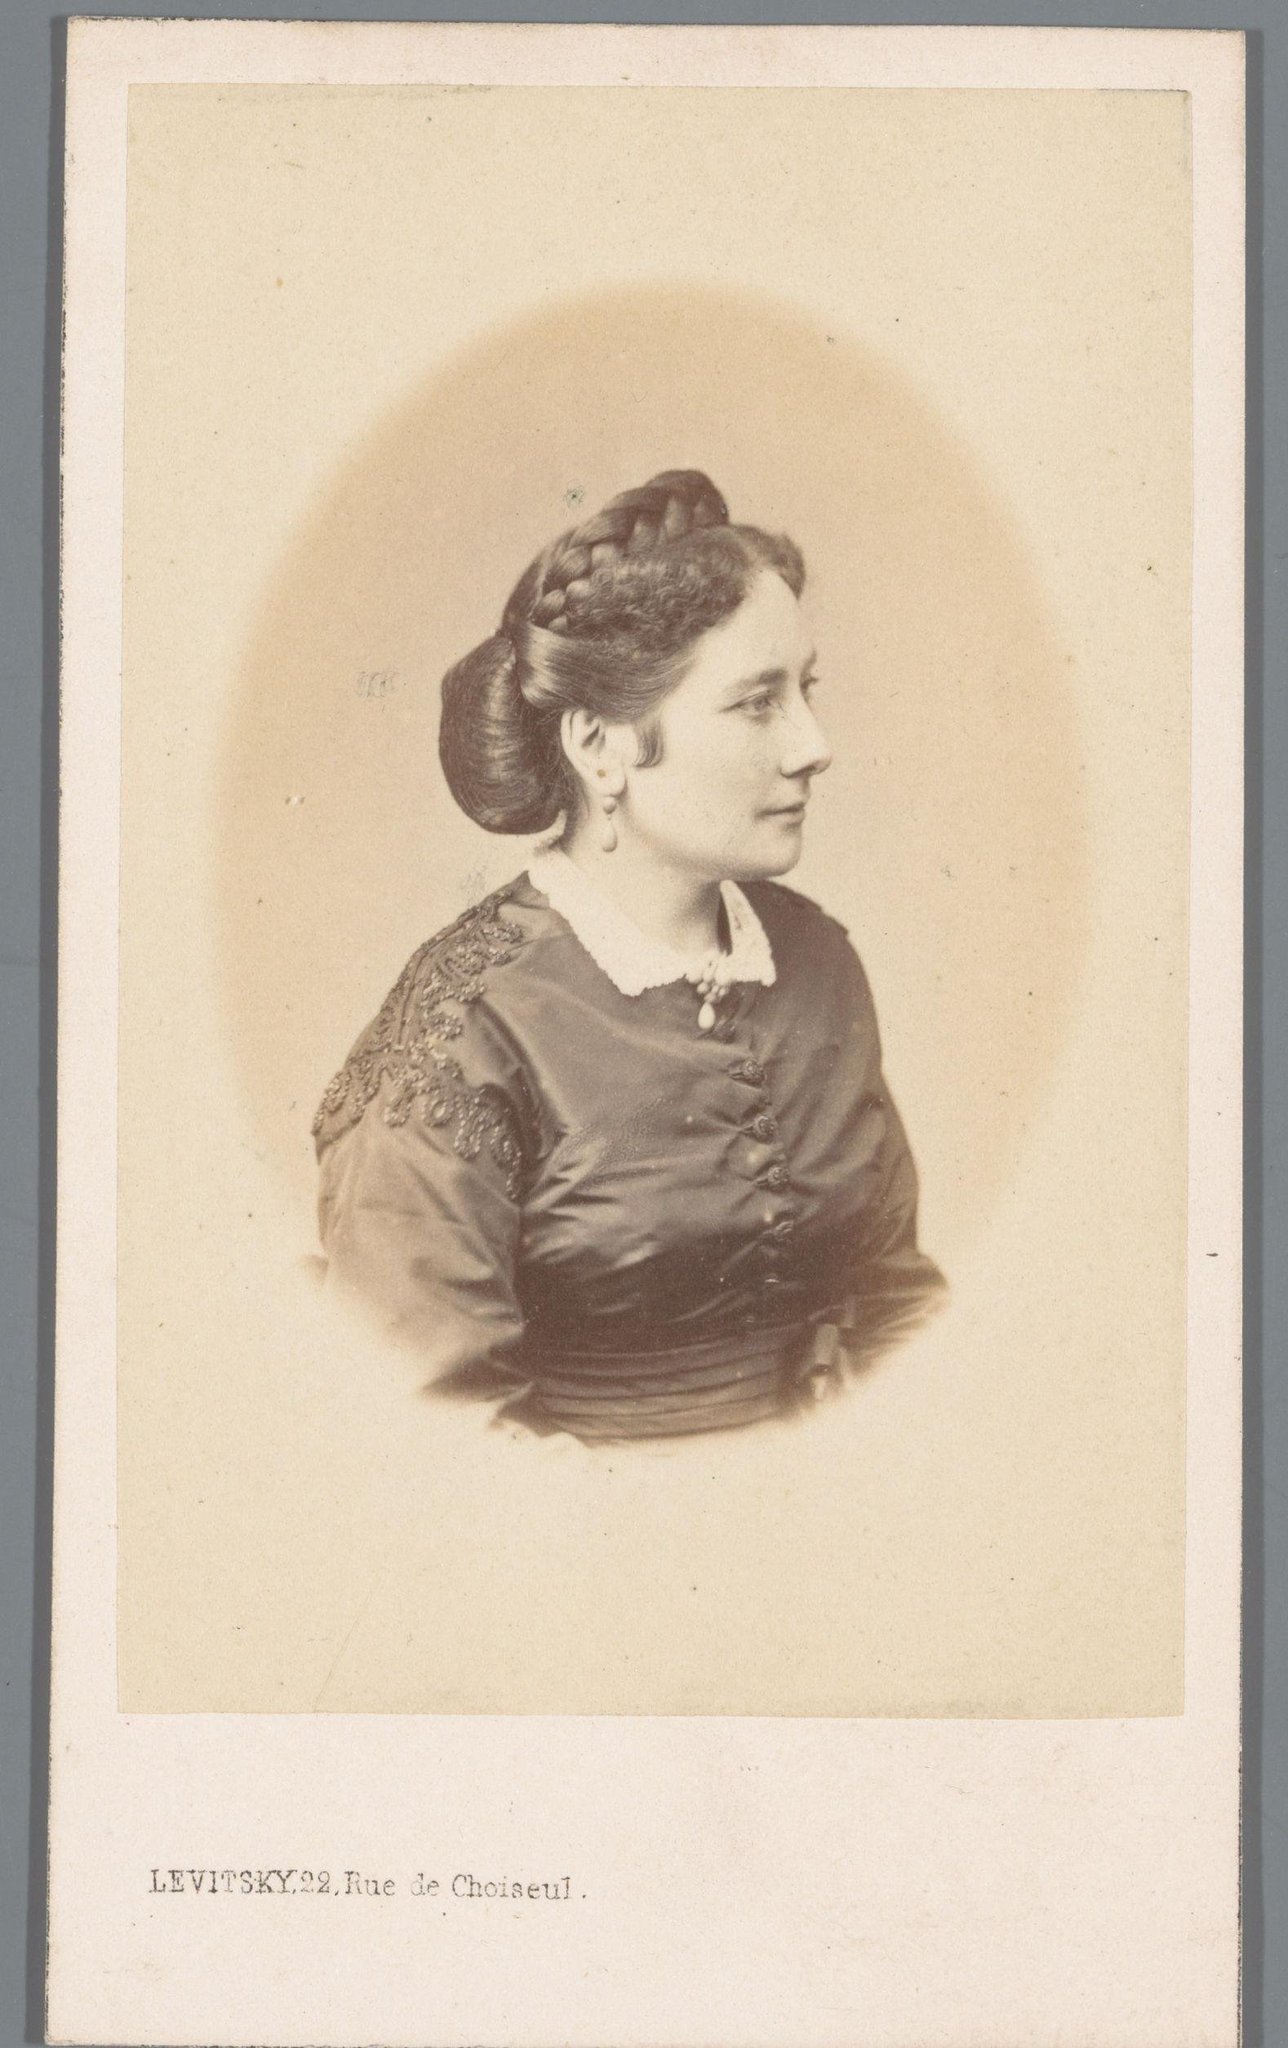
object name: photograph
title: Portret van een onbekende vrouw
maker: sergei lvovich levitsky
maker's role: fotograaf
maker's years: 1819-1898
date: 1858-1865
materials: cardboard, paper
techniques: albumen print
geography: paris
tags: adult woman, anonymous historical person portrayed, paris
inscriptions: inscription: ‘Levitsky. 22, Rue de Choiseul.’